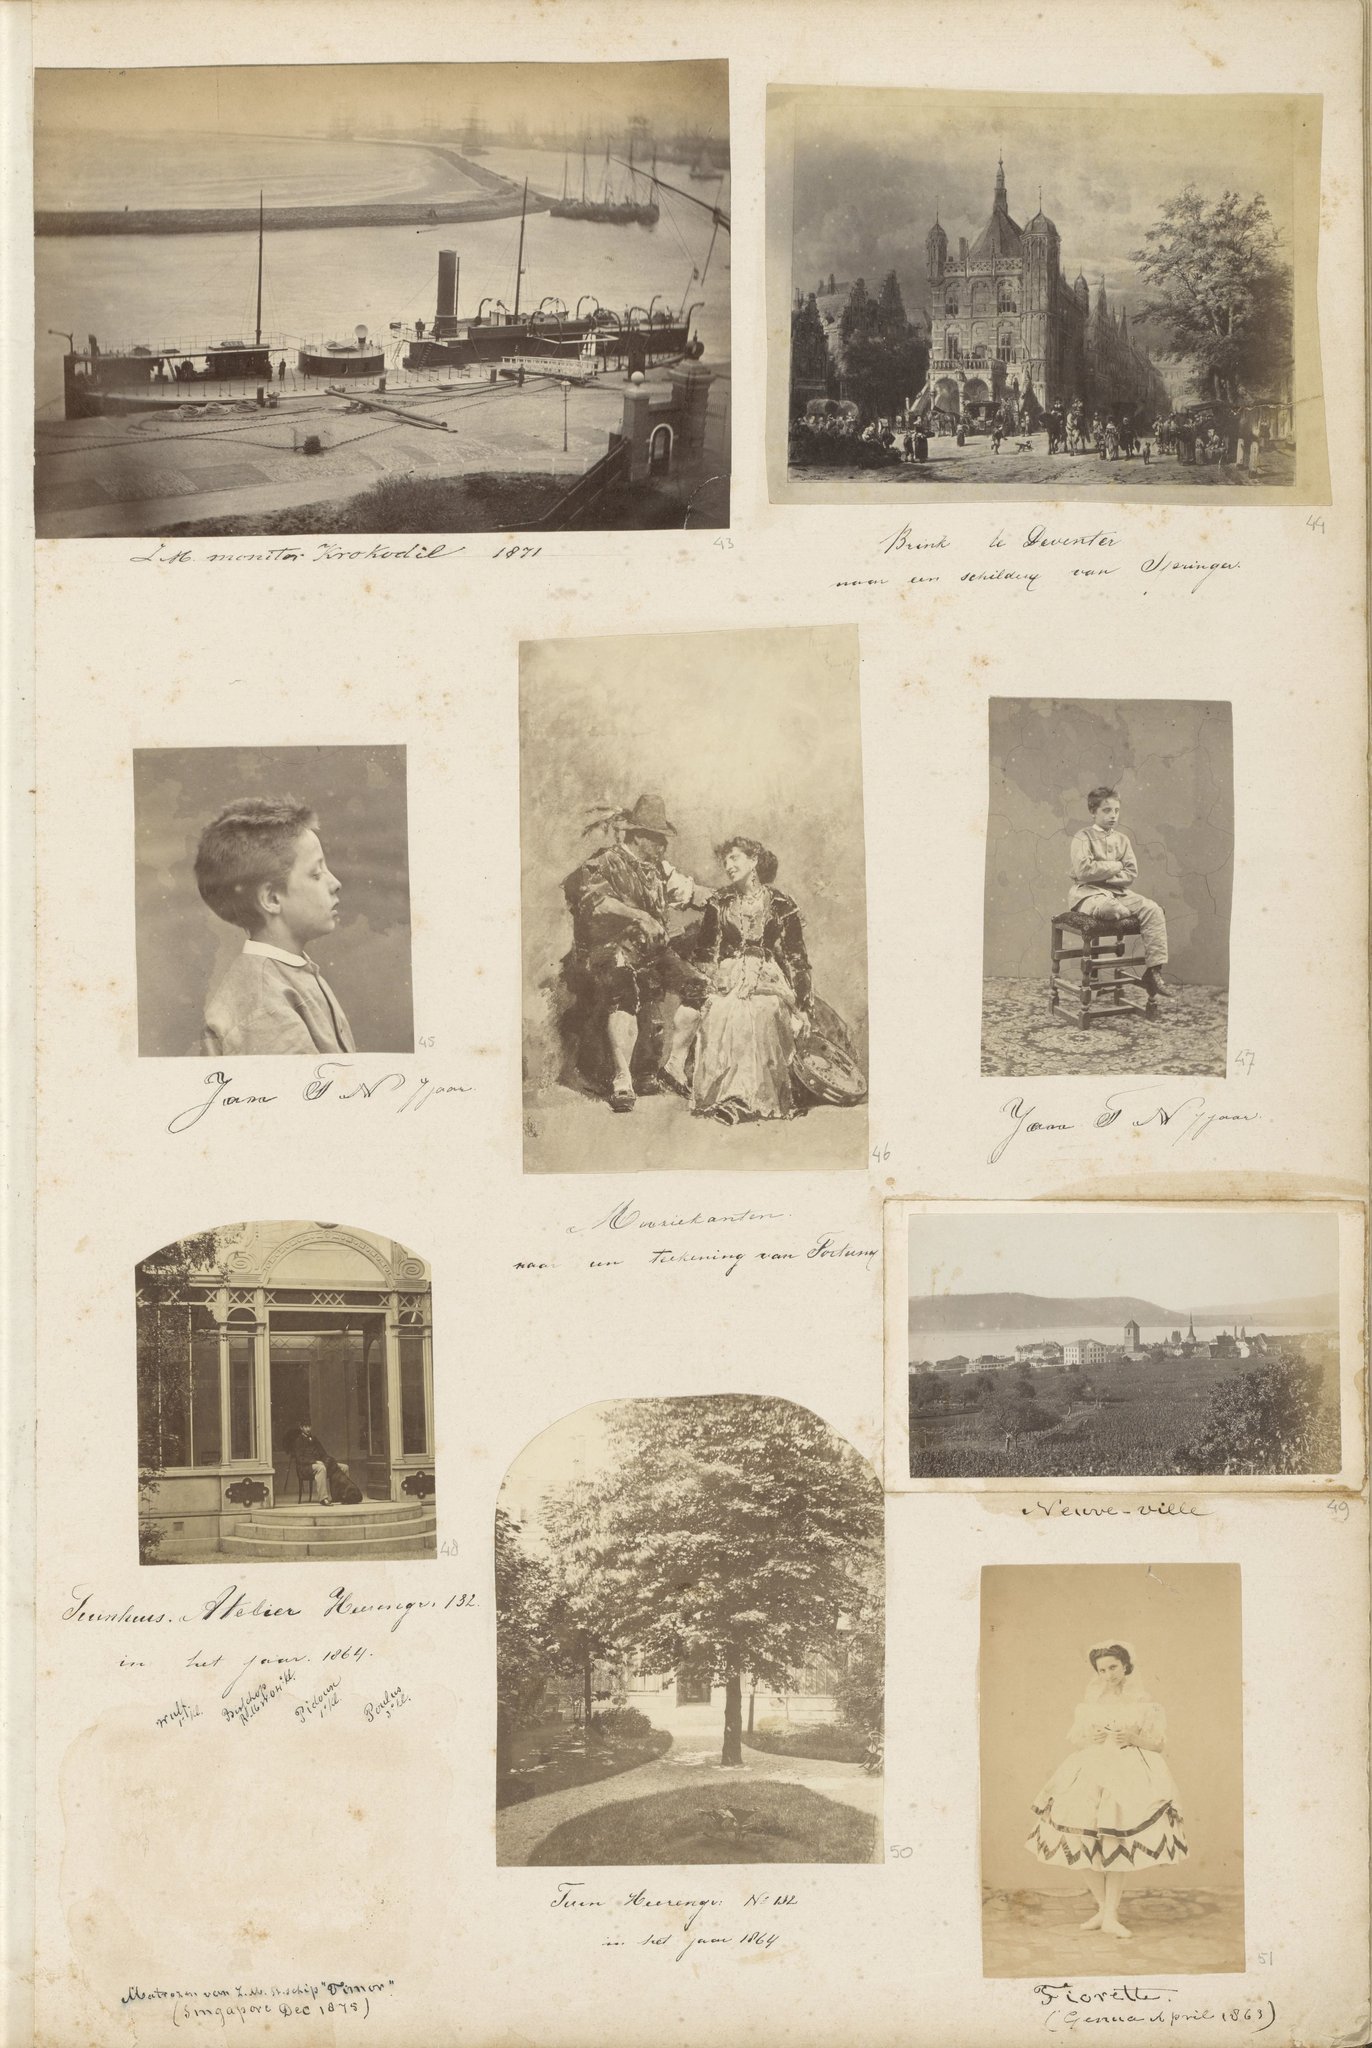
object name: photograph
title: Gezicht op Neuve-Ville aan de Bielersee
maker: Anonymous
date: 1860-1870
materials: cardboard, paper, photographic support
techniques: albumen print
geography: switzerland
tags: prospect of village, silhouette of village, switzerland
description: Onderdeel van Fotoalbum van Robert Daniel Crommelin (1841-1907).